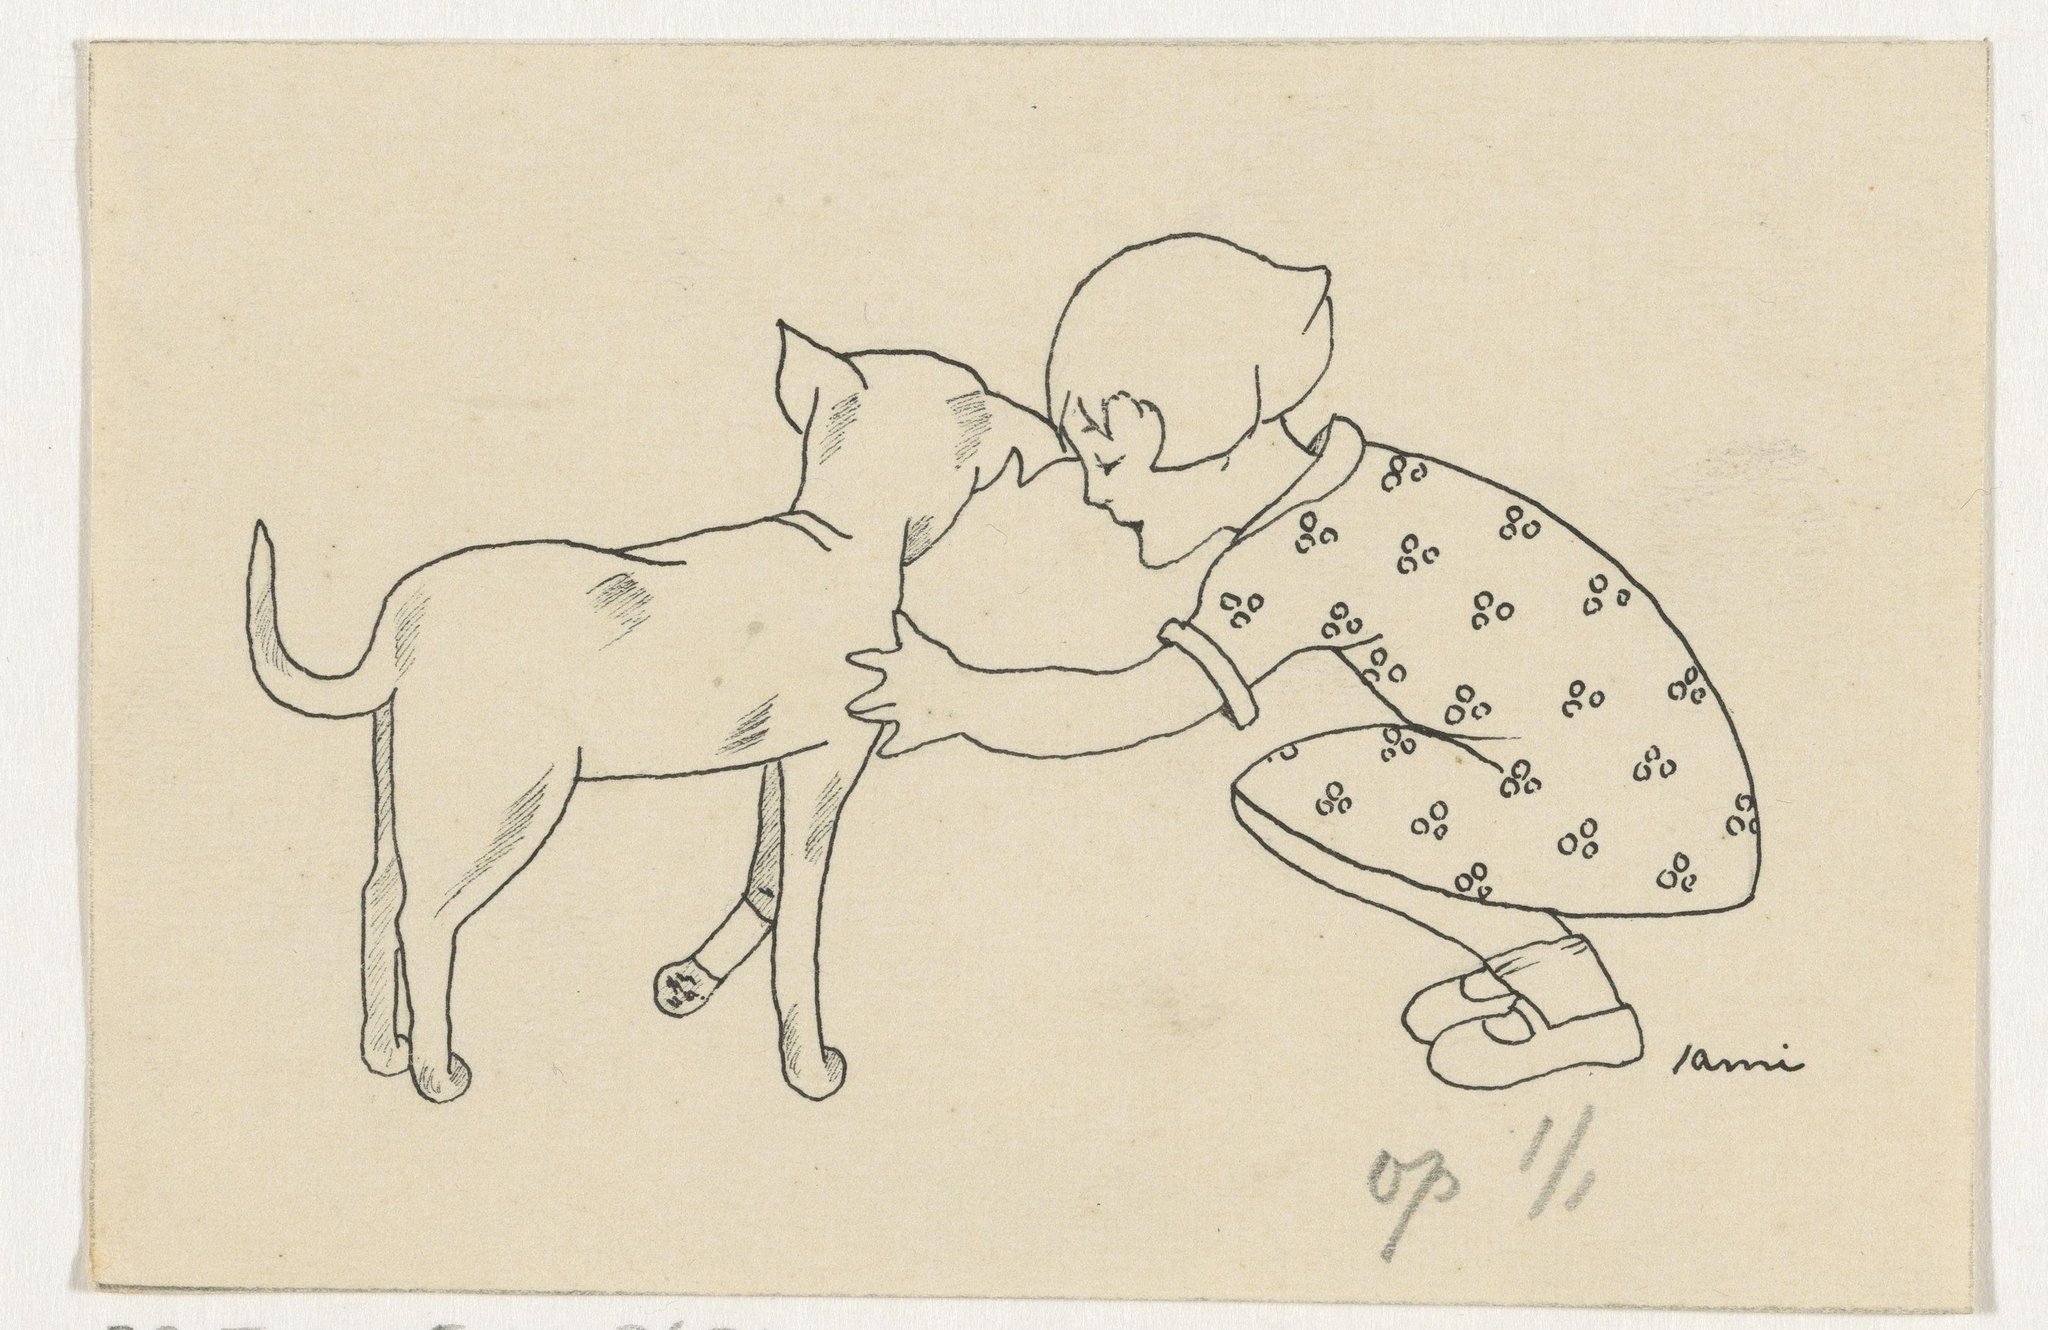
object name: drawing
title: Meisje knuffelt een hond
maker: Anonymous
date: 1880-1930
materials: ink, paper, pencil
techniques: pen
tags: dog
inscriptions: :, collector's mark: Lugt 2228a, signature: ‘lami’